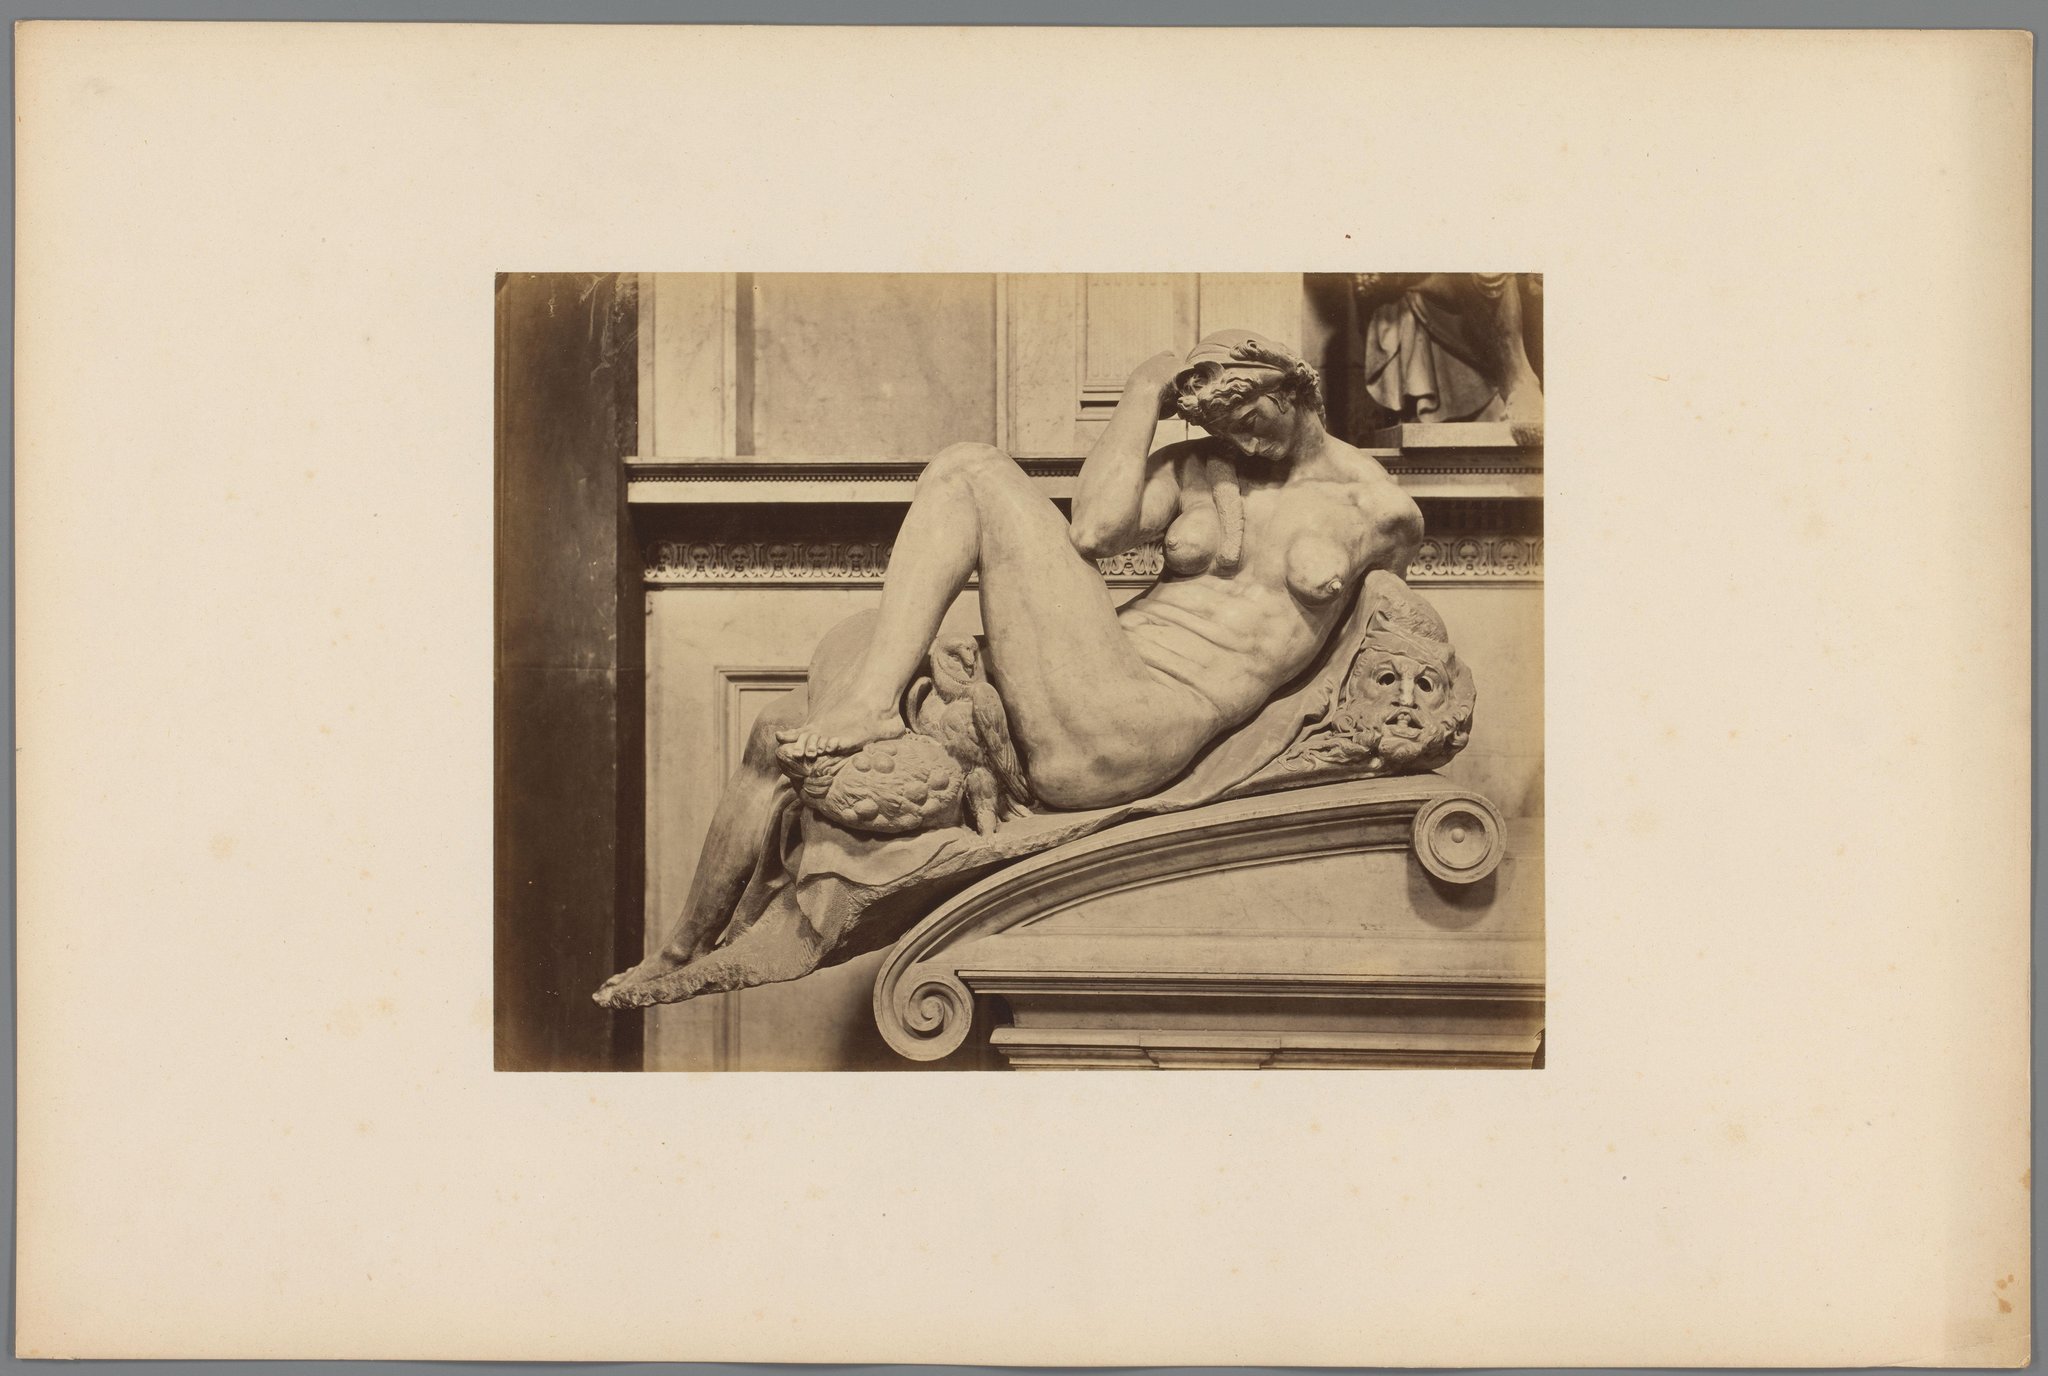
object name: photograph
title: Detail van het grafmonument voor Giuliano de' Medici naar Michelangelo te Florence, Italië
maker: Anonymous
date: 1851-1900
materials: cardboard, paper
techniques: albumen print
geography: florence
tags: piece of sculpture, reproduction of a piece of sculpture